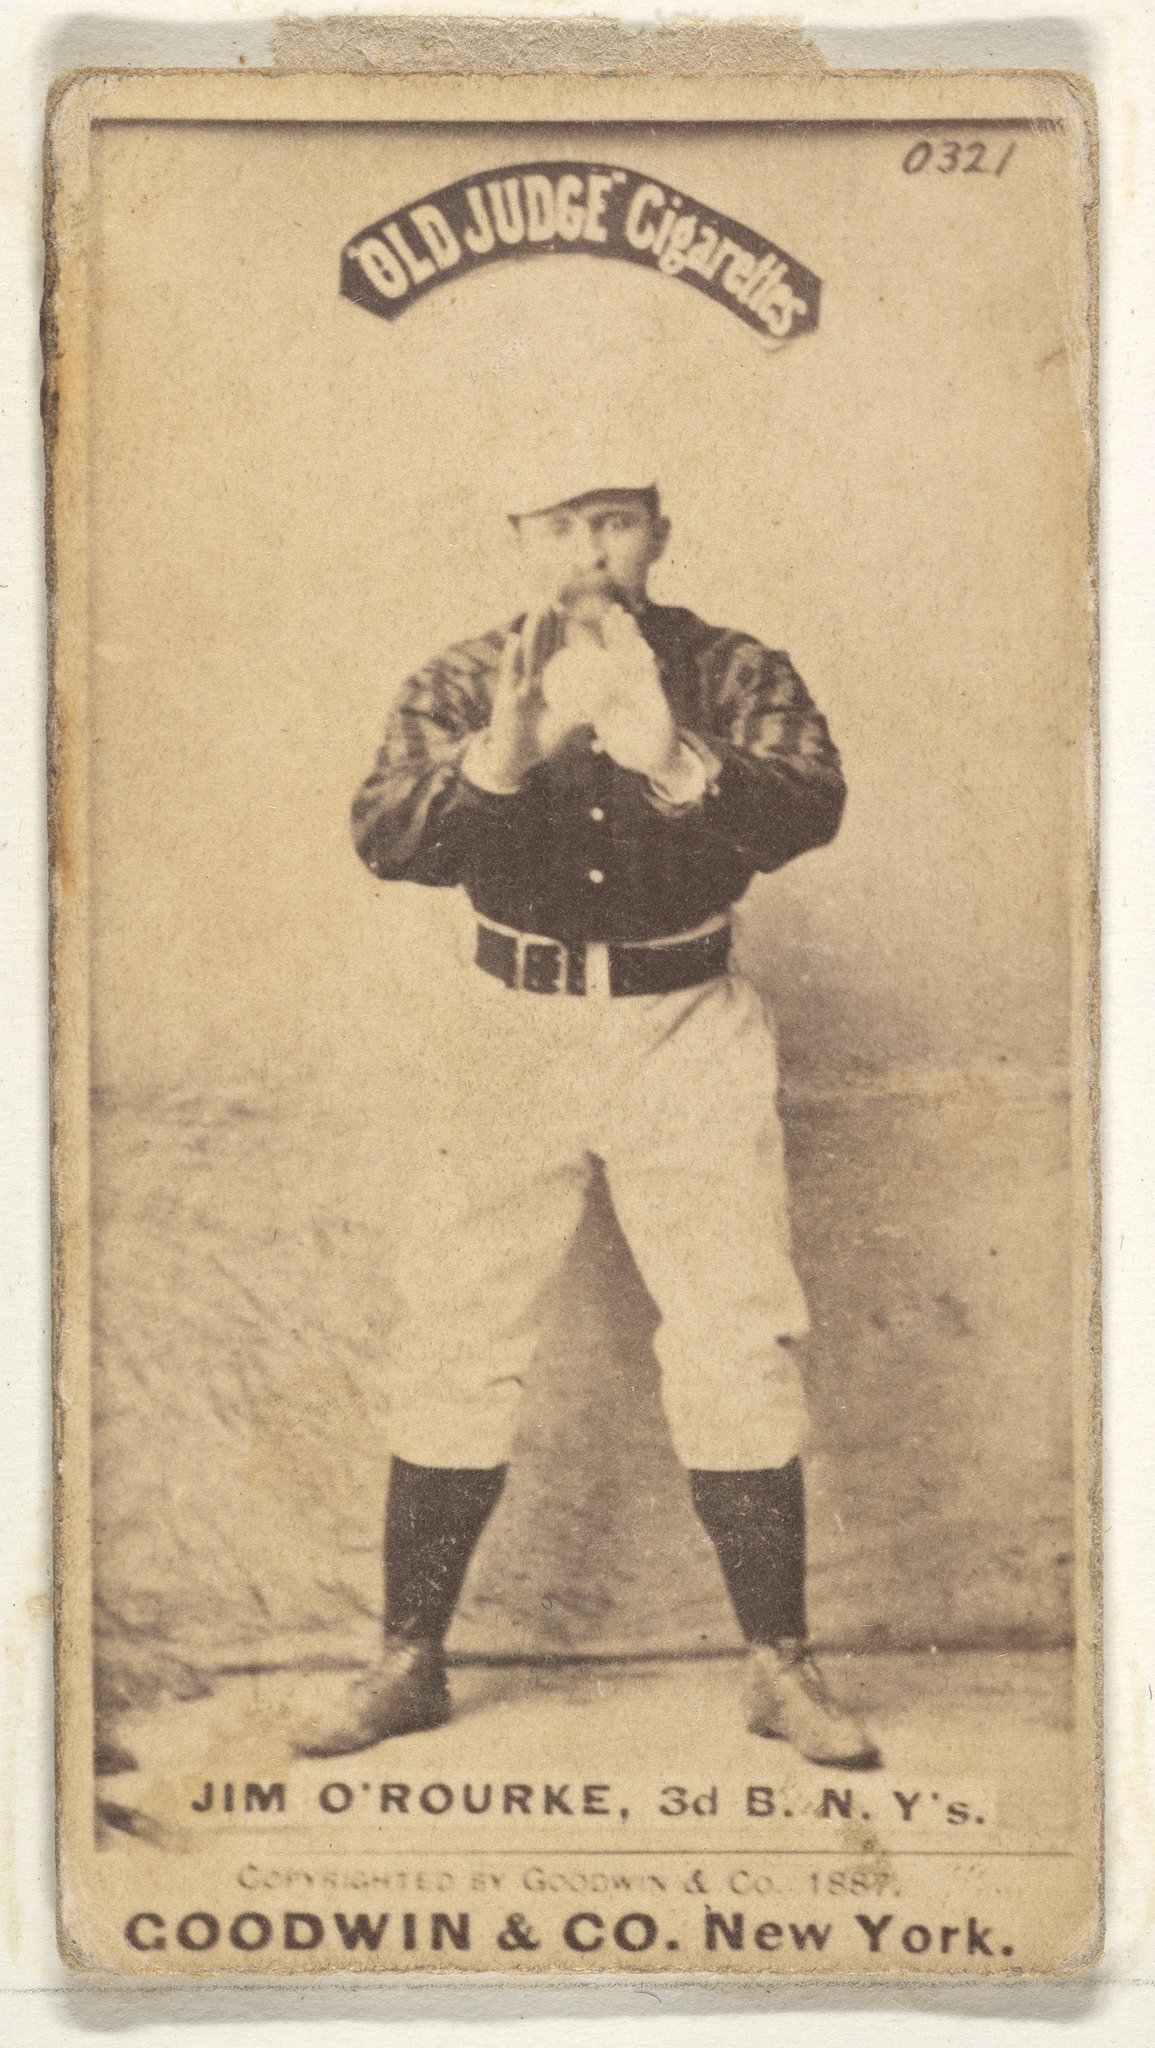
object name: baseball card, photograph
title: James Henry O'Rourke, 3rd Base, New York, from the Old Judge series (N172) for Old Judge Cigarettes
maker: goodwin & company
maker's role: publisher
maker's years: 1850-1950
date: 1887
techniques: albumen silver print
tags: men,portraits,baseball,athletes